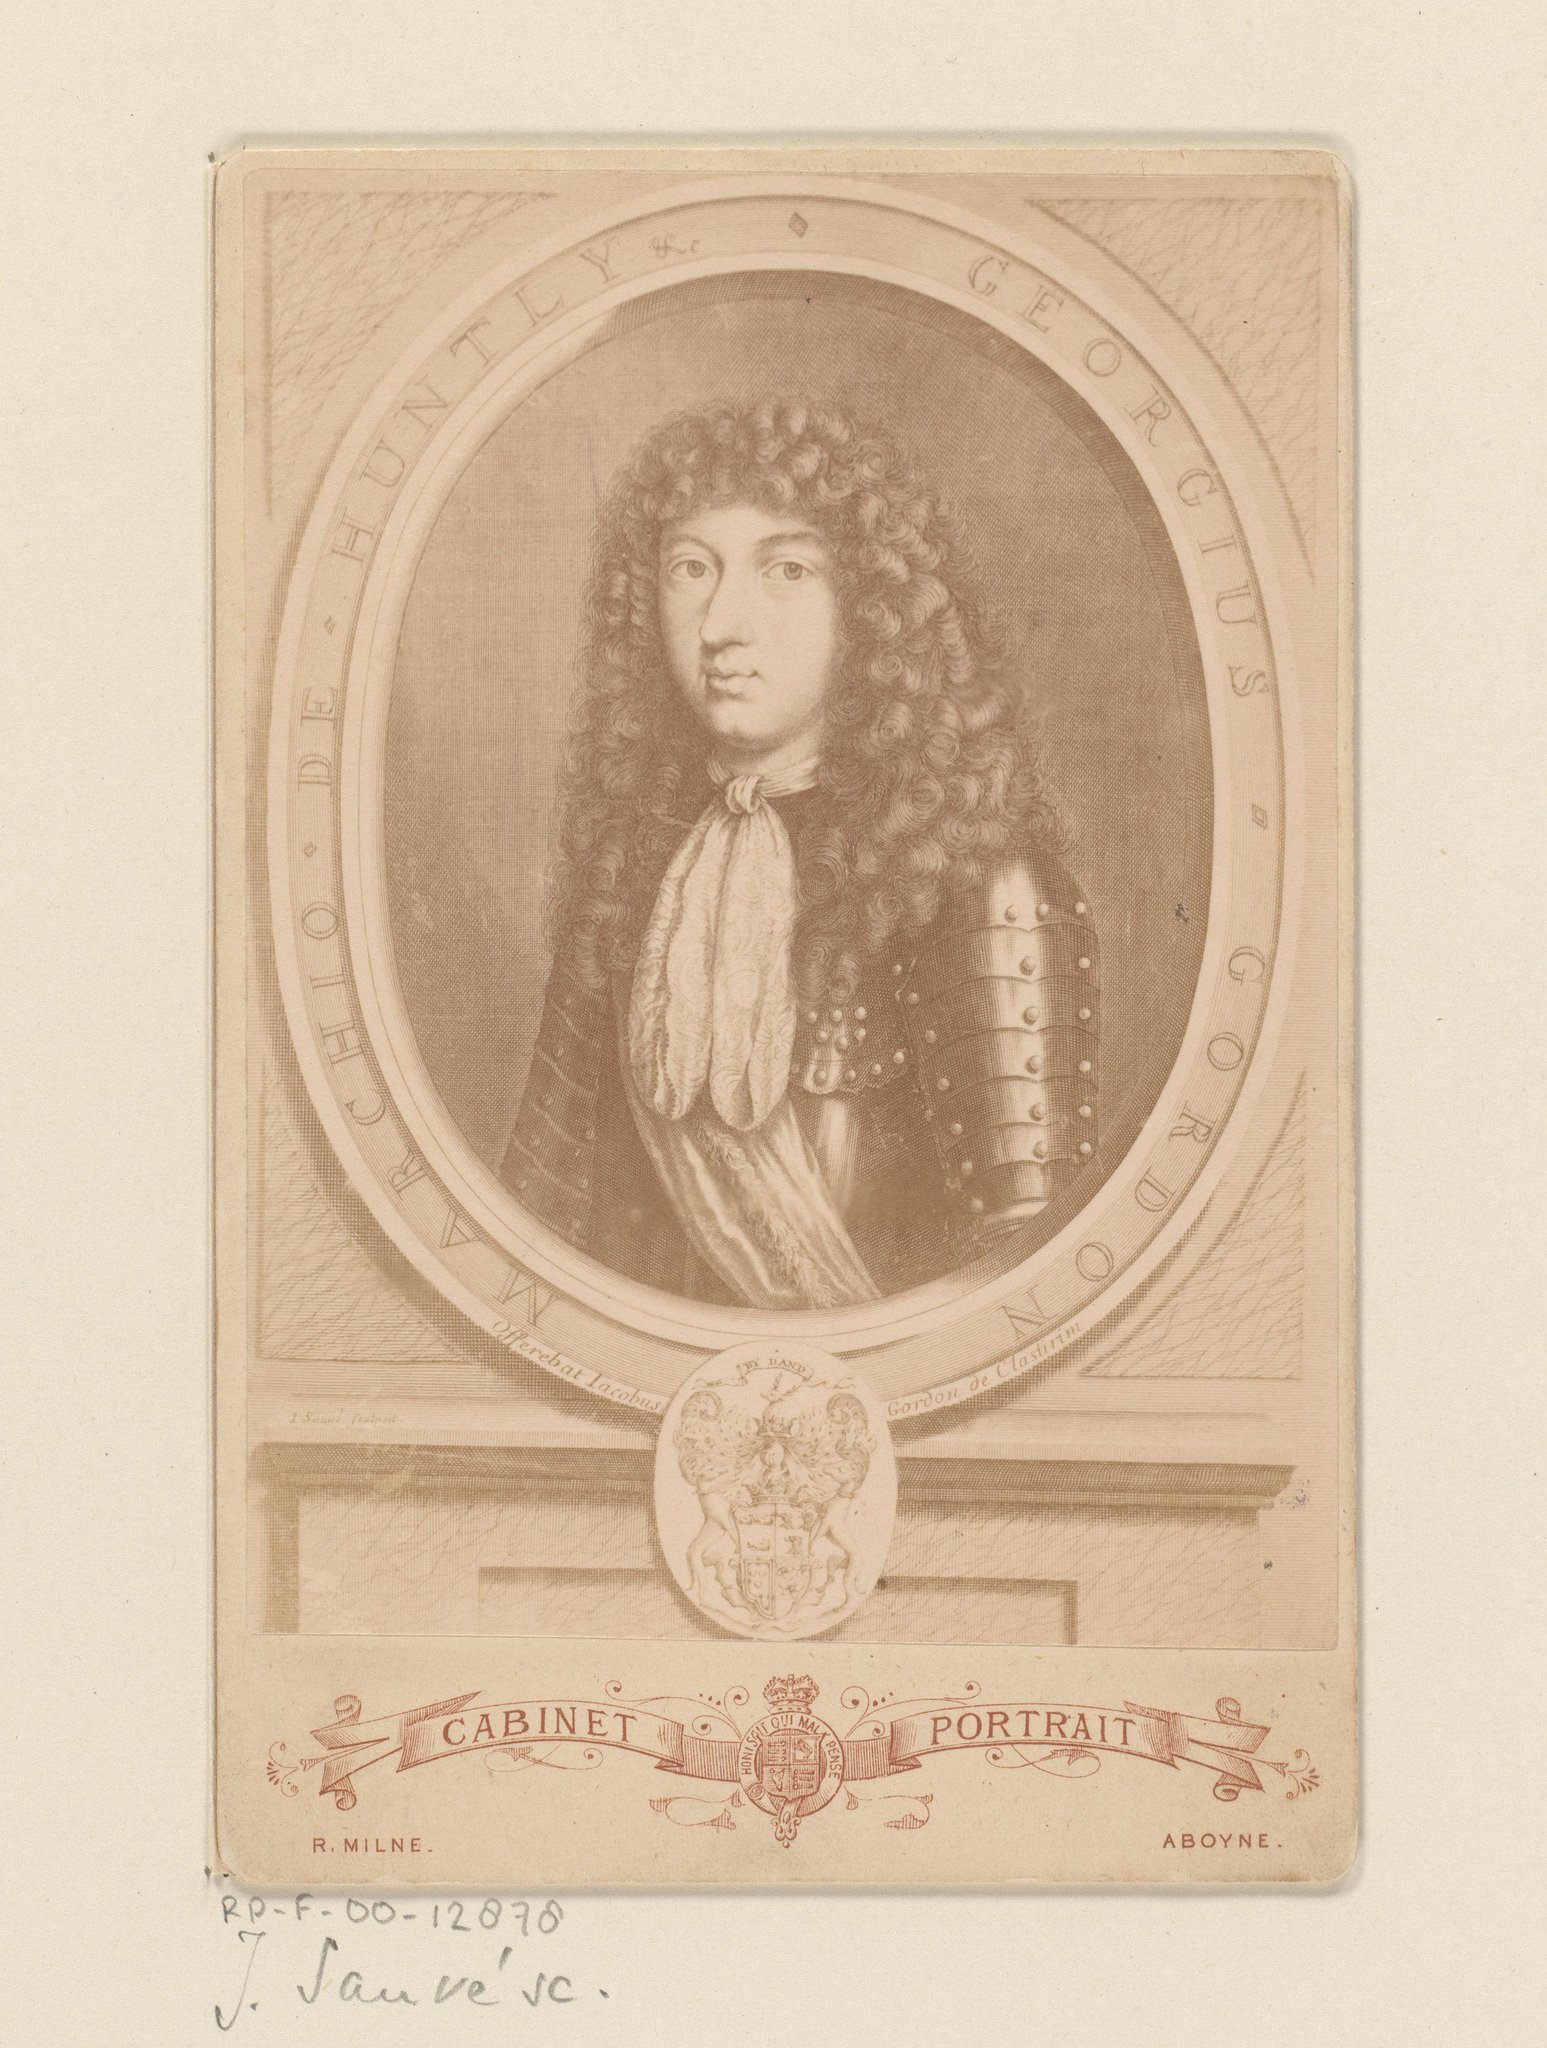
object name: cabinet photograph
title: Fotoreproductie van een gegraveerd portret van George Gordon Huntly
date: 1930-1950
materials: cardboard, paper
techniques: albumen print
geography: aboyne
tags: print, e.g.: engraving, etching, lithograph, historical persons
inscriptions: inscription: ‘INSTANTANEOUS PORTRAITS OF CHILDREN/ Portrait & Landscape/ PHOTOGRAPHER/ R MILNE/ ABOYNE/ COPIES CAN ALWAYS BE HAD/ PORTRAITS ENLARGED TO ANY SIZE/ AND/ FINISHED IN OIL WATER COLOR OR CRAYON./ OUT DOOR WORK UNDERTAKEN/ AT MODERATE CHARGES.’, inscription: ‘CABINET PORTRAIT/ R. MILNE. ABOYNE./’